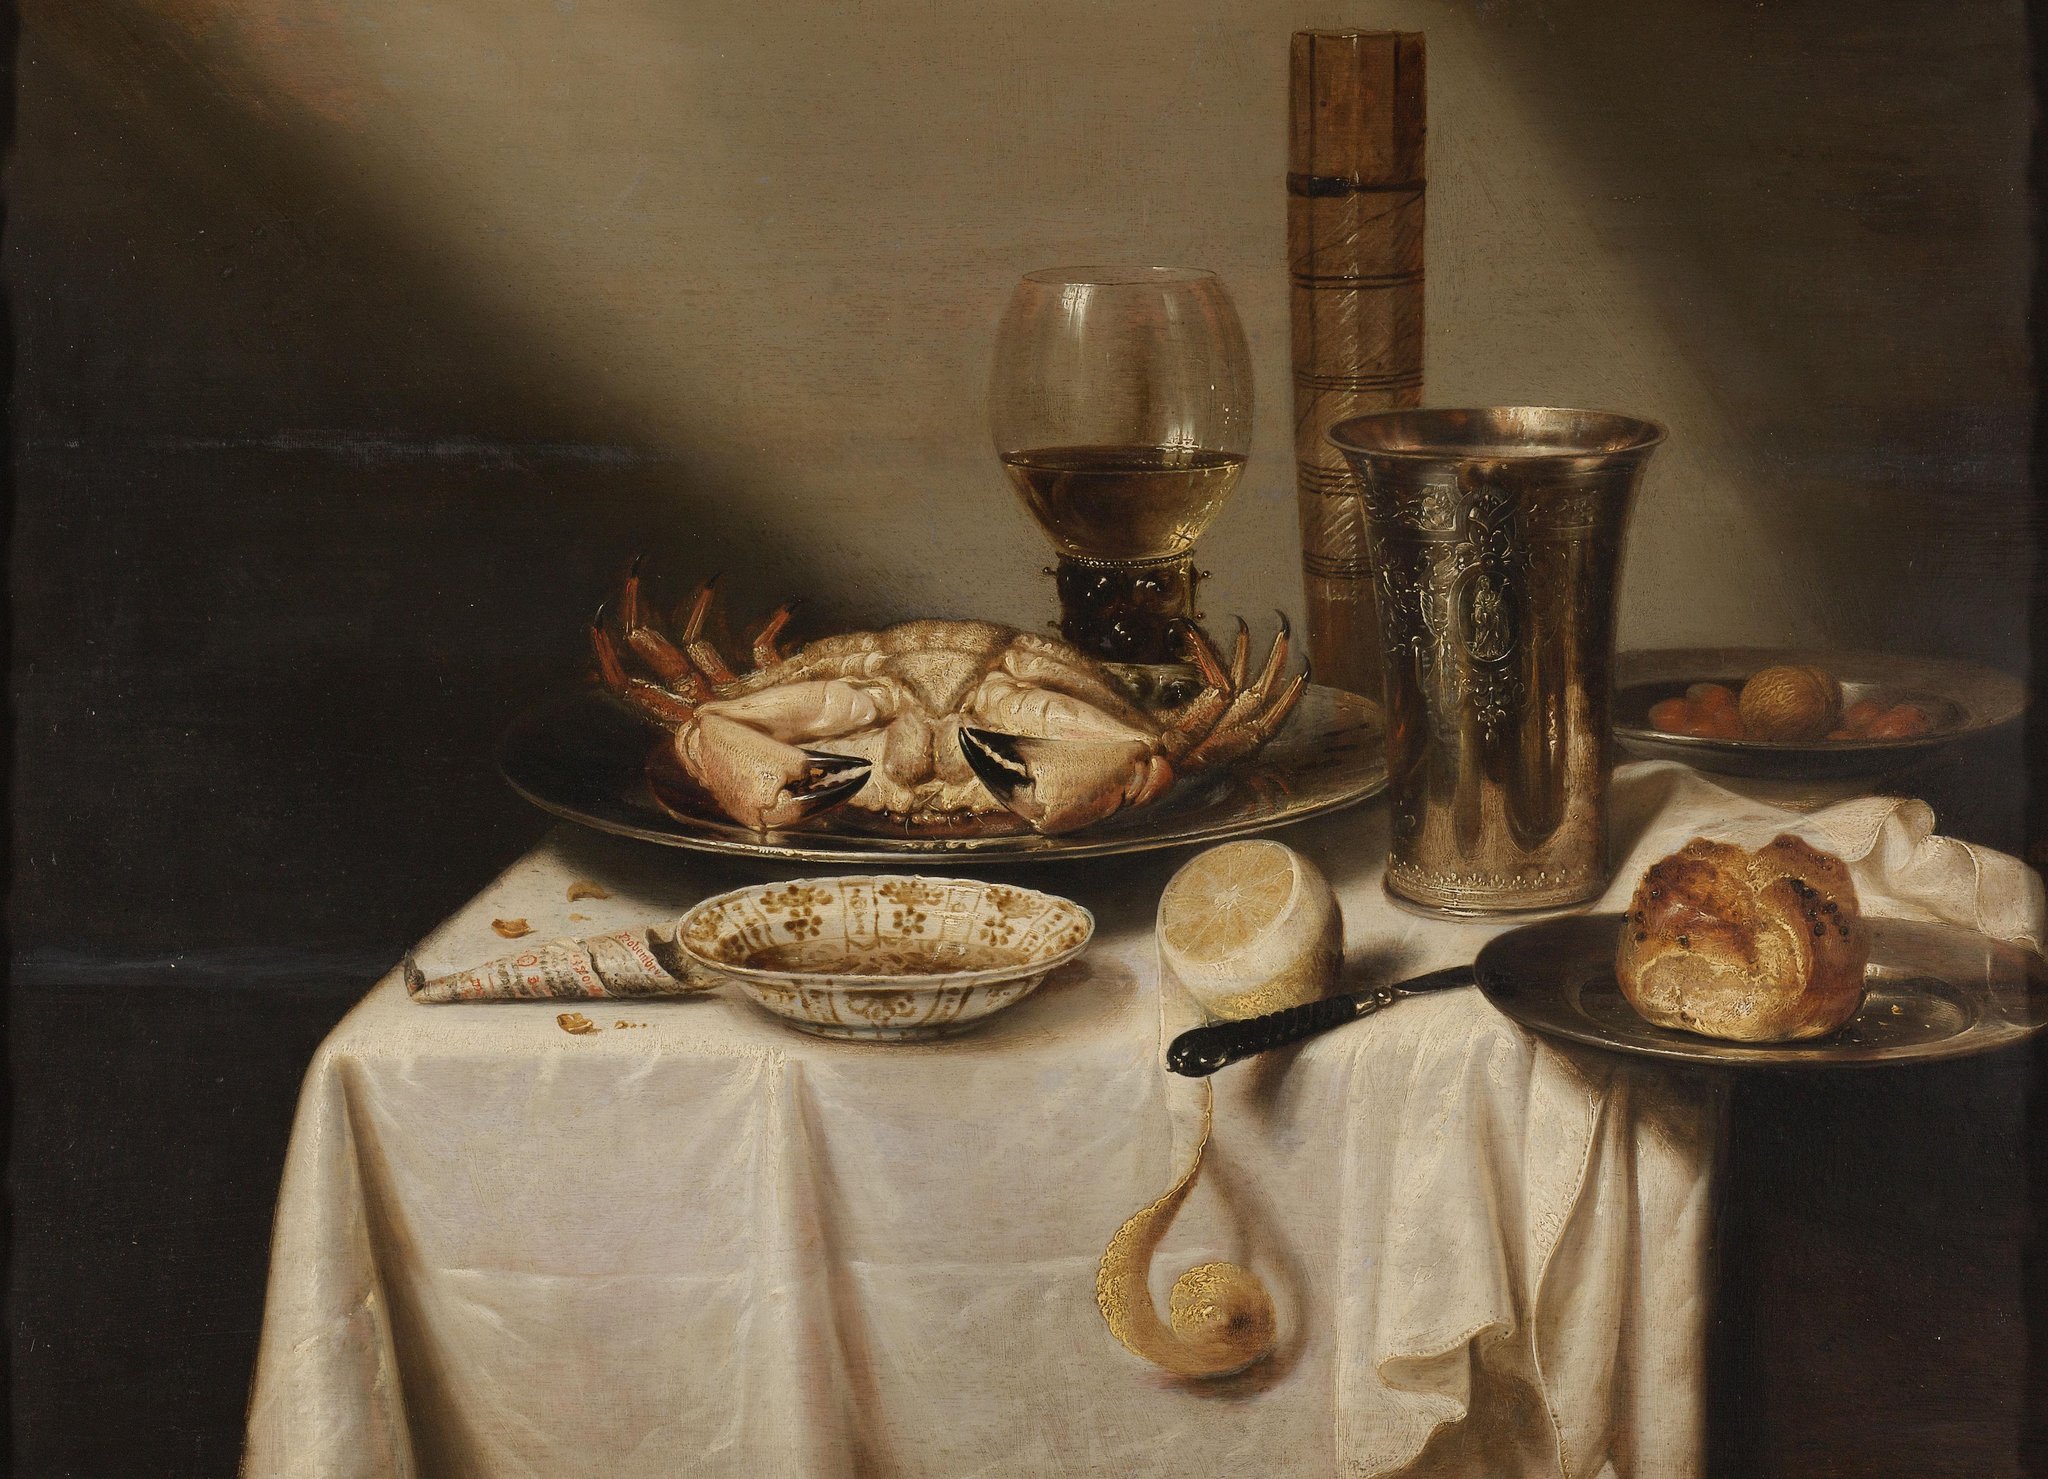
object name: painting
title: Stilleven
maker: jan albertsz. rotius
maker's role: painter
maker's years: 1624-1666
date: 1644-1666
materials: oil, panel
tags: still life of related objects, foodstuffs; still life of foodstuffs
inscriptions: signature and date: ‘JRotius 16..’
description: Stilleven. Op een tafel met een wit laken staan een tinnen schaal met een krab, een Chinees bordje, een halfgeschilde citroen, een roemer met witte wijn, een pasglas, een zilveren beker, een bord met noten en een bord met een broodje. Links vooraan een opgerold papier met peper.